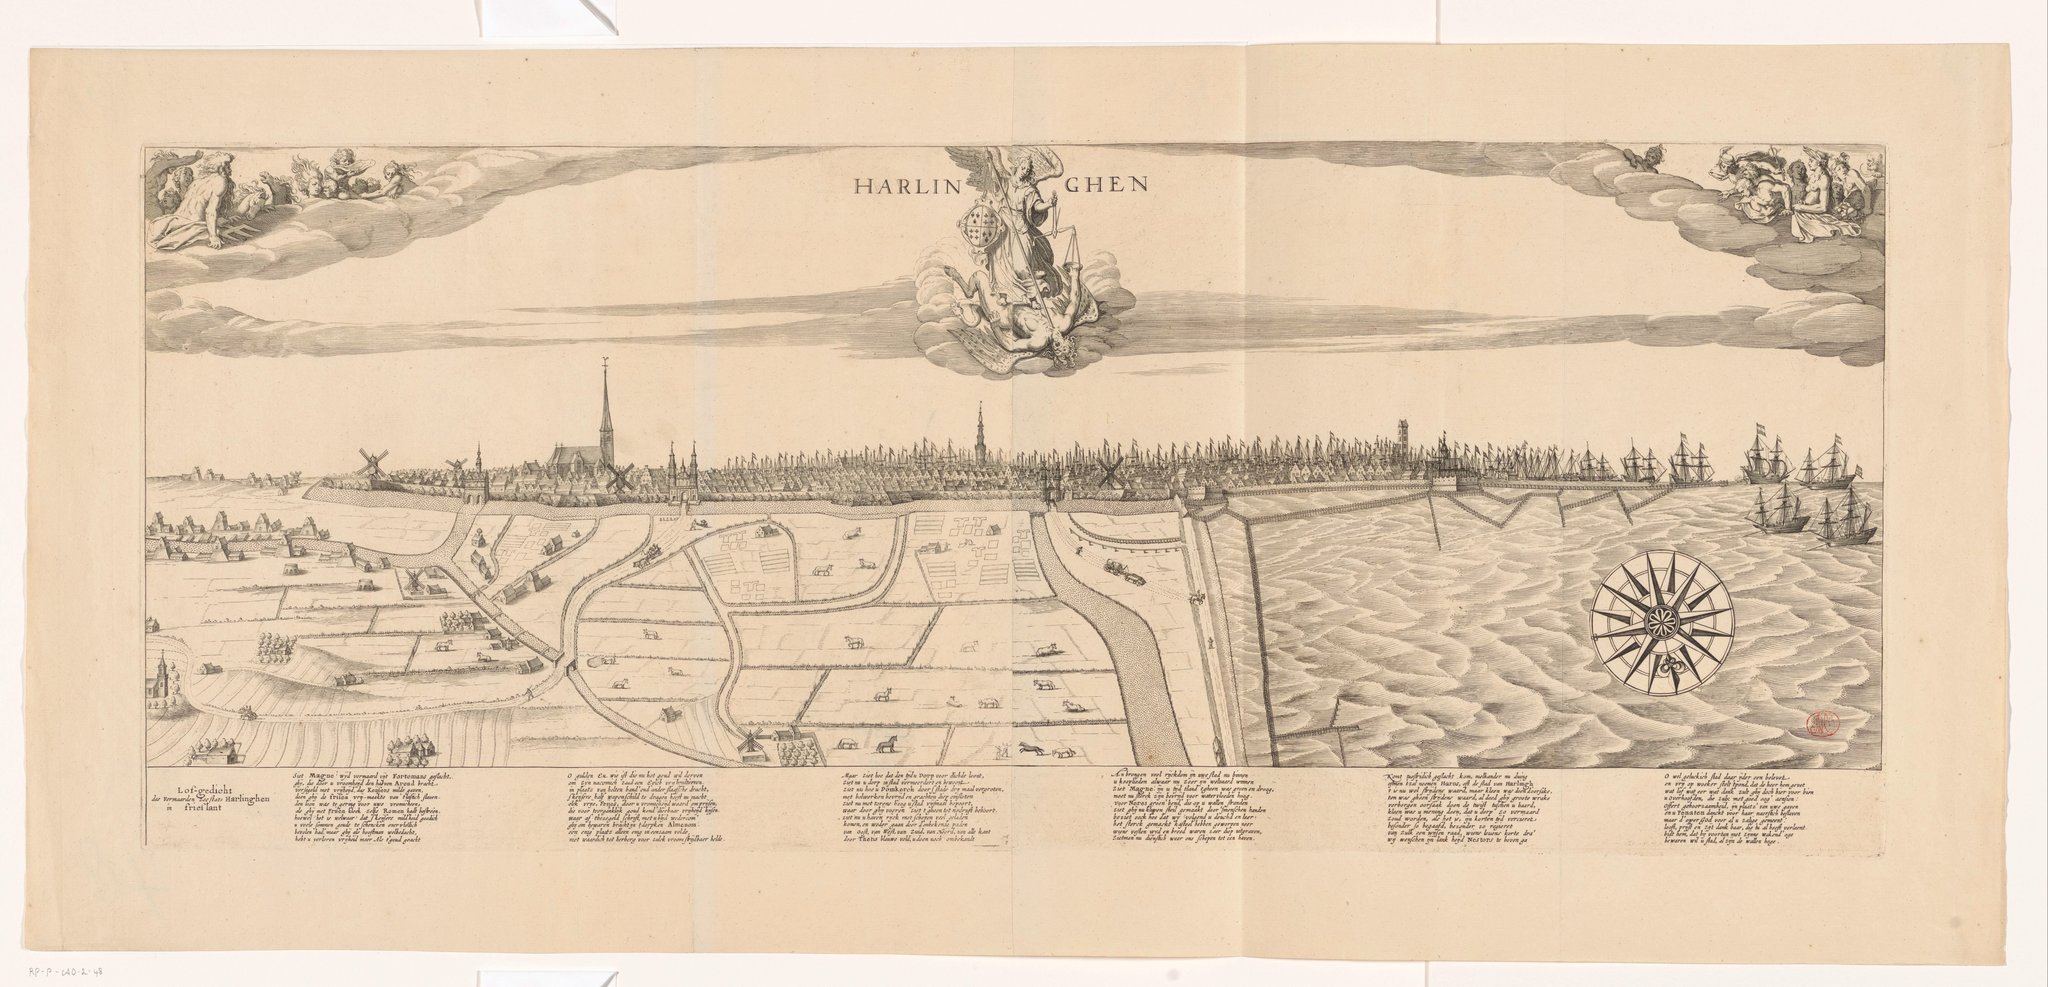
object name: print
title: Harlighen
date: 1614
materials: paper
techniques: engraving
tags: (story of) neptune (poseidon), coat of arms (as symbol of the state, etc.), city-view, and landscape with man-made constructions, the archangel michael fighting the dragon (devil, satan), (story of) mercury (hermes), harlingen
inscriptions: collector's mark: Lugt 2228, label: ‘264’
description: Linksboven in de wolken een aantal figuren waaronder Neptunus. In het midden bovenaan de titel en de aartsengel Michaël, patroonheilige van Harlingen, met het wapen van de stad. Hij staat op een duivelachtig vrouwfiguur met slangenhaar, vleugels, bokkenpoten en een staart. Rechtsboven in de wolken een aantal figuren waaronder Mercurius. Onderaan de prent een lofdicht over de stad.